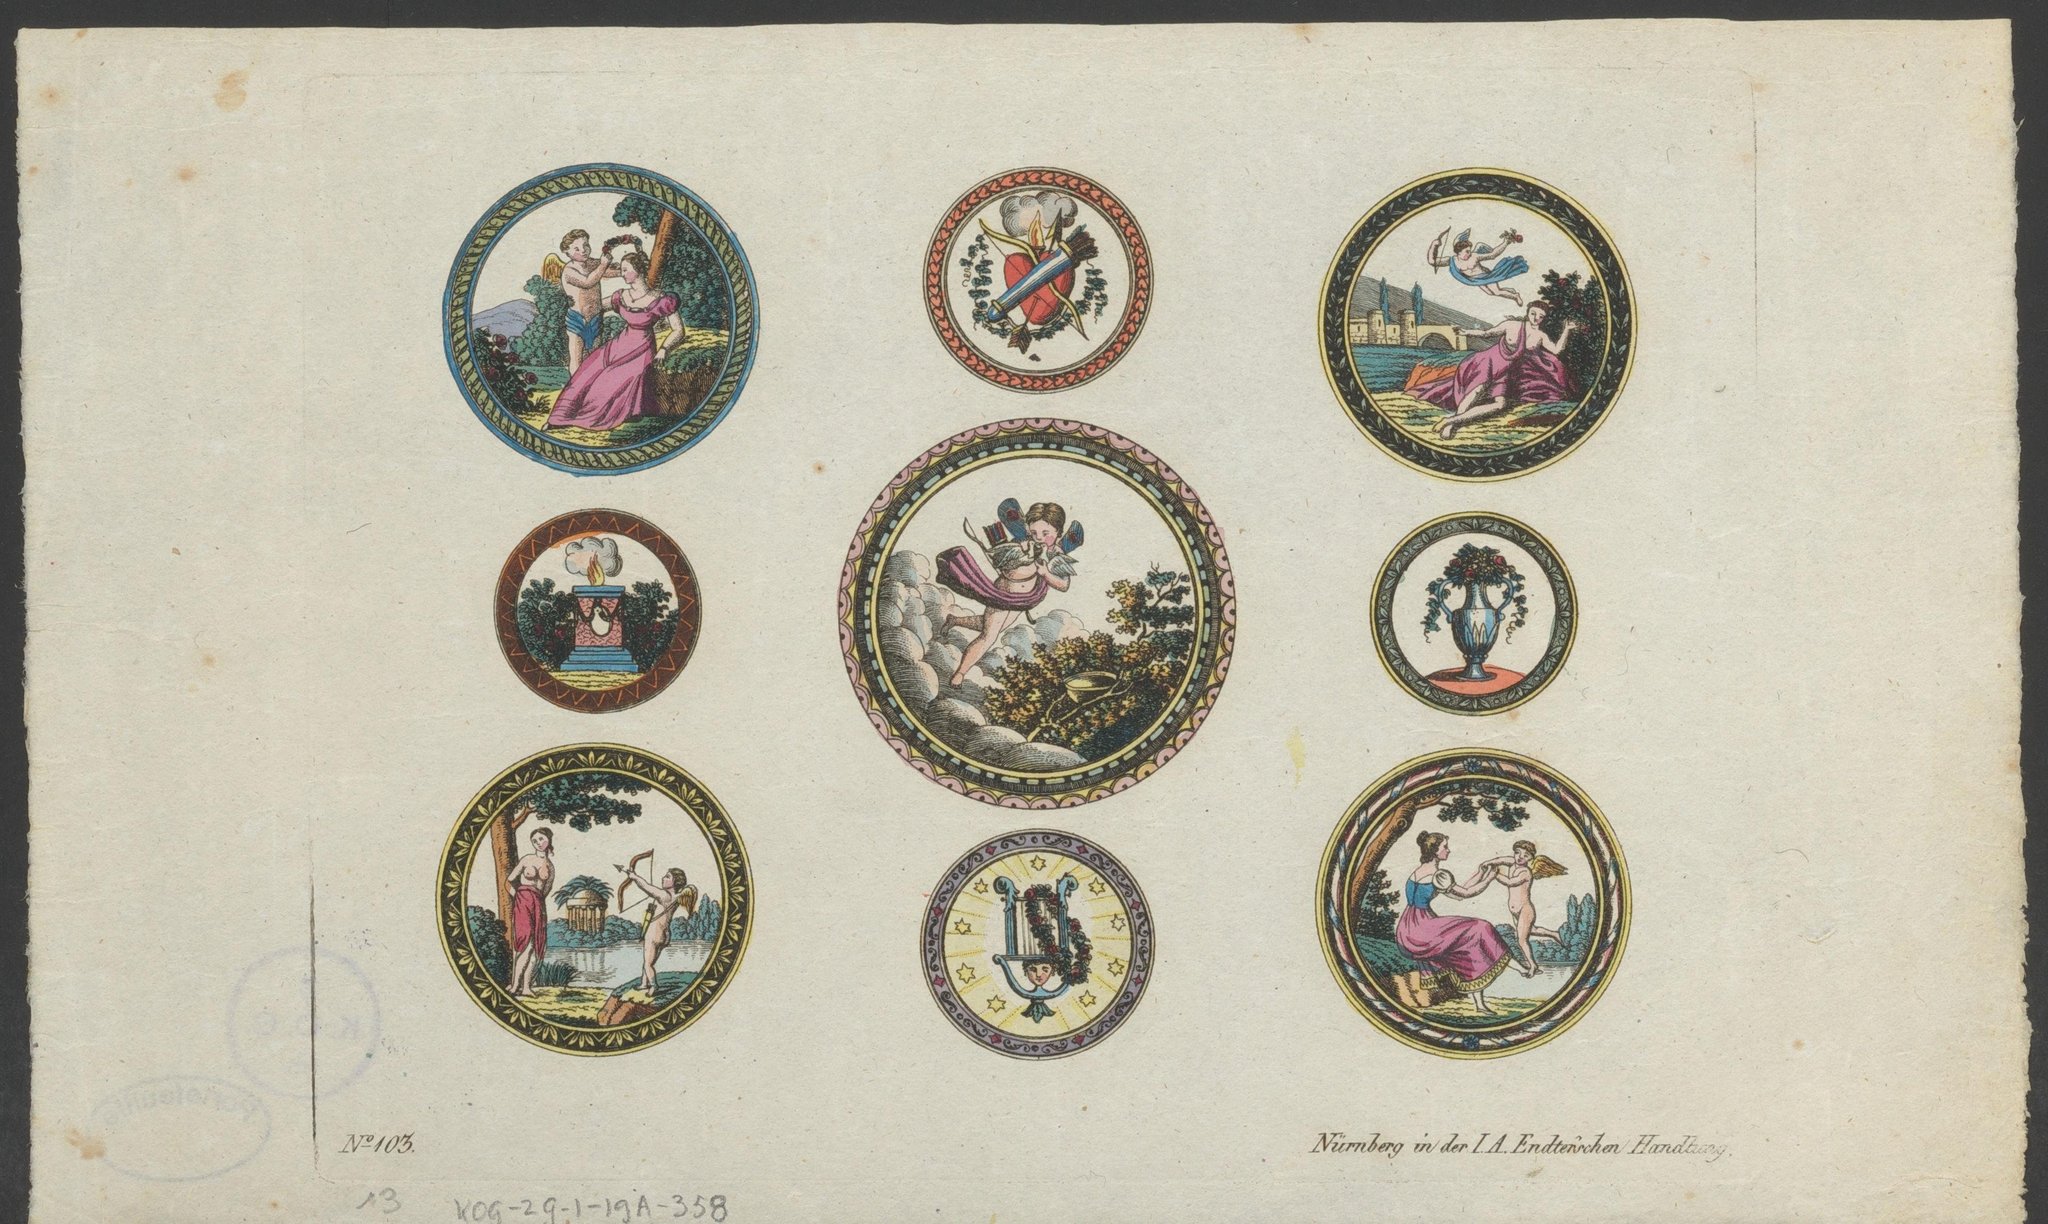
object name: print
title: Cupido en zijn attributen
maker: Anonymous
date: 1800-1854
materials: paper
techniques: engraving, etching, hand coloring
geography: nuremberg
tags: attributes of cupid: bow and arrow, (story of) cupid, amor (eros), attributes of cupid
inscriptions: stamp, collector's mark: Lugt 1641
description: Negen medaillons met scènes met cupido en attributen. Linksonder genummerd: No. 103. Onderwerpsrubrieken binnen de Atlas Zeden en Gewoonten: Zeden en Gewoonten in Engeren Zin, Des menschen beging, midden en einde, Kinderleven – Kinderspel en Kinderprenten.